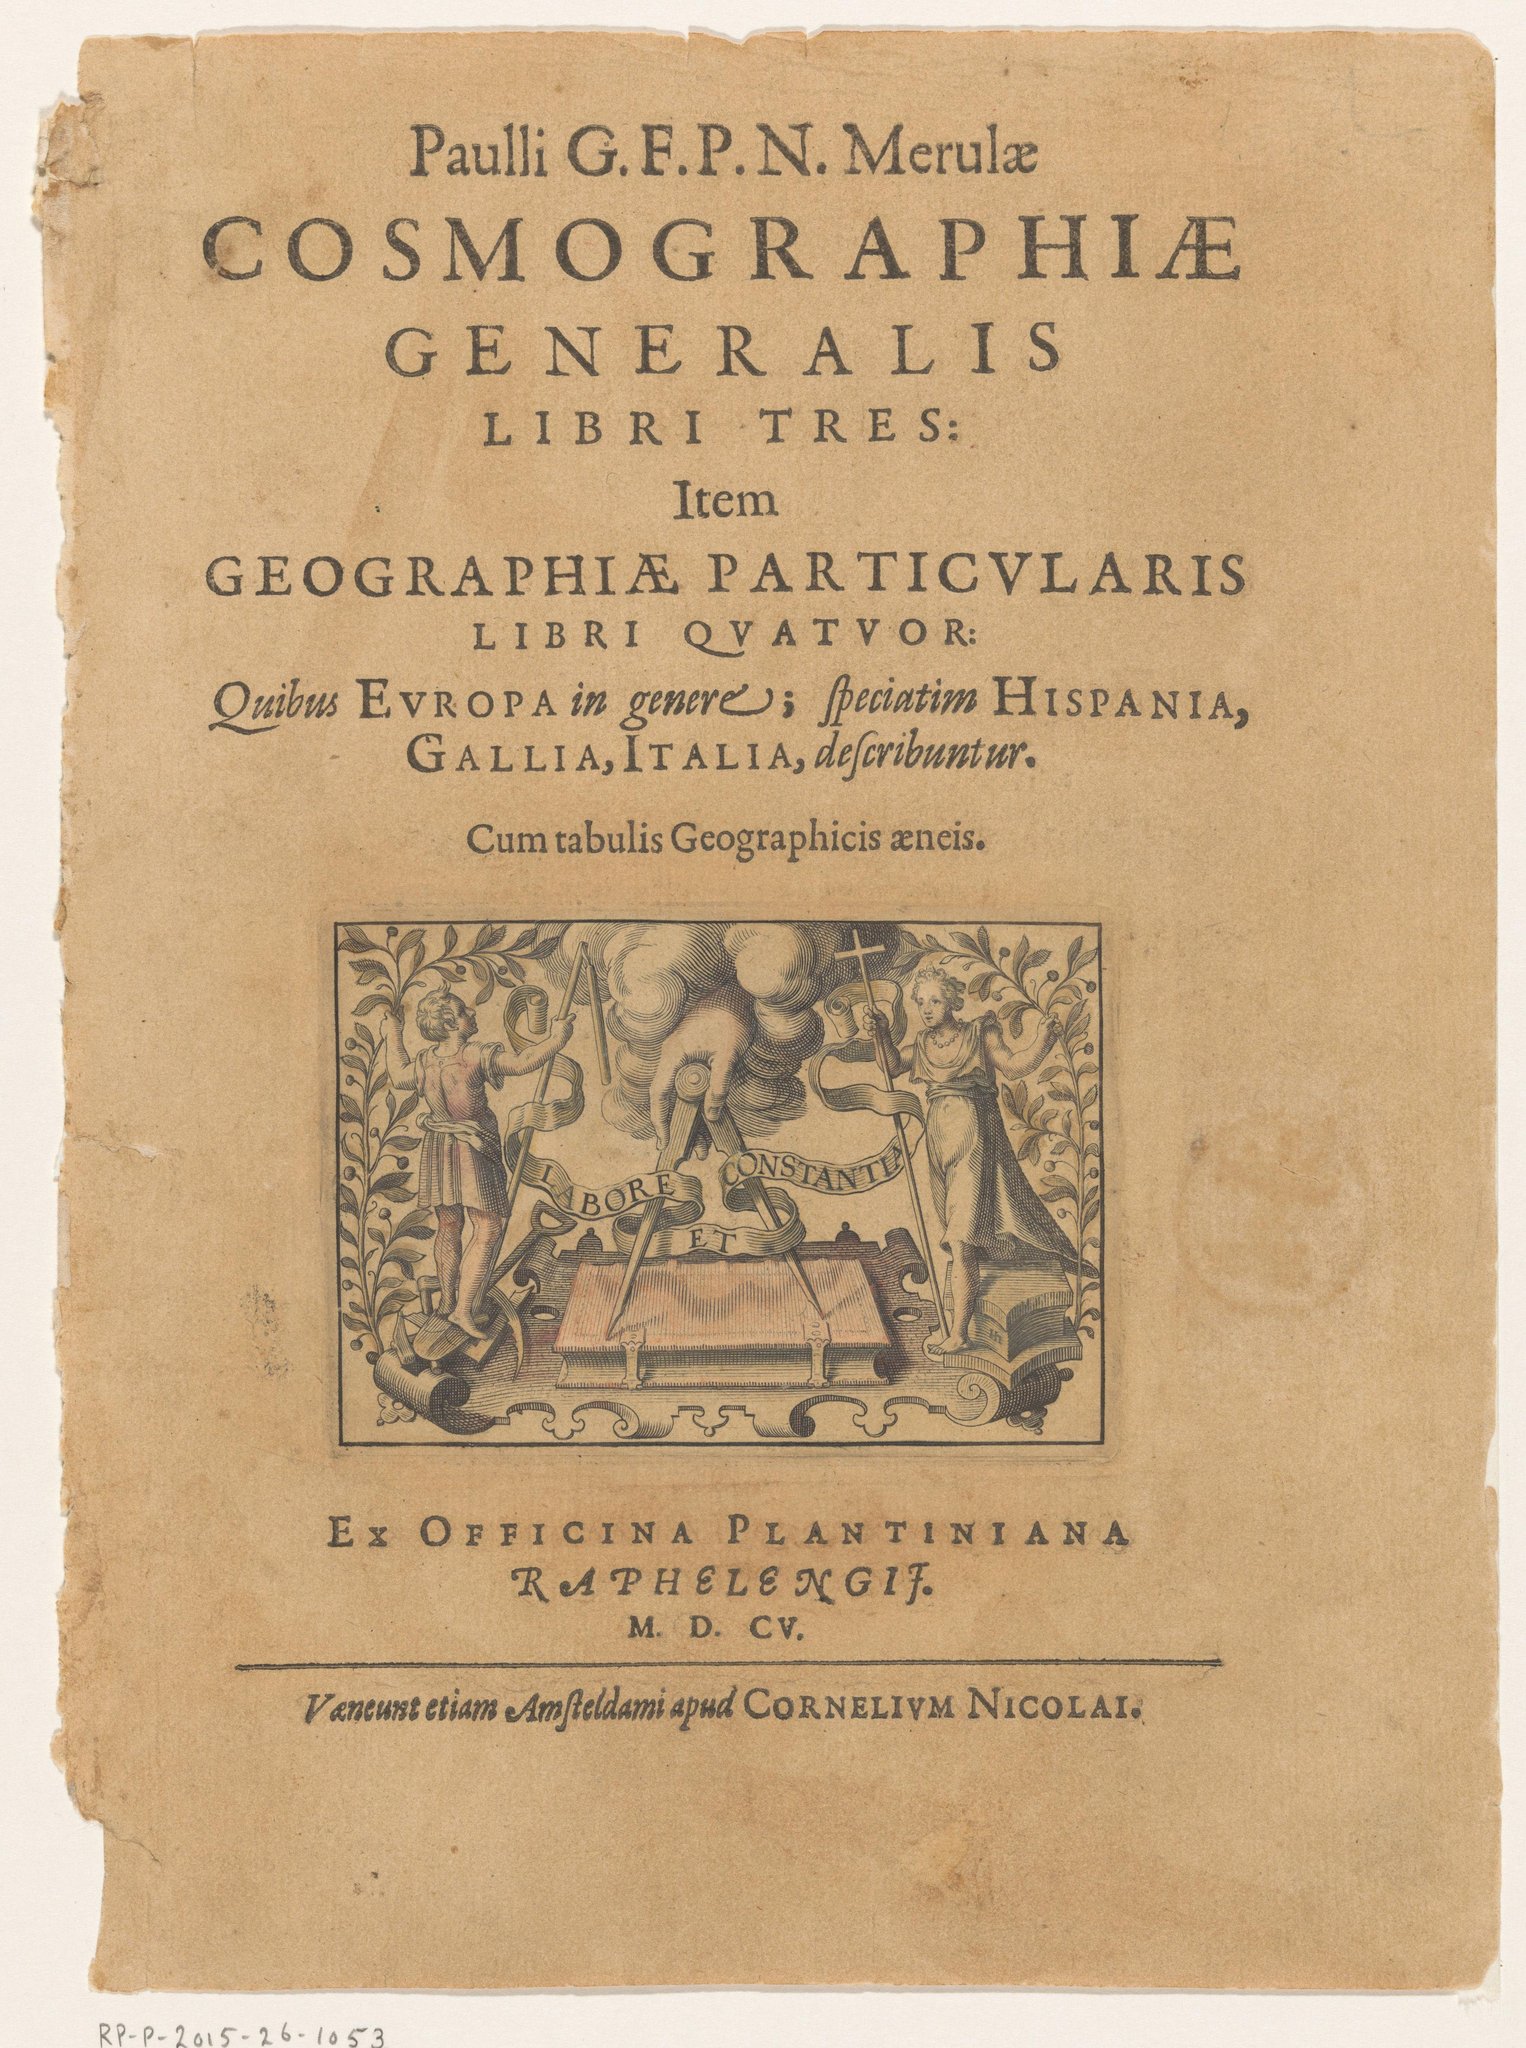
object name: print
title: Passer op een boek met Arbeid en Standvastigheid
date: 1605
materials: paper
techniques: engraving, hand coloring, letterpress printing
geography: amsterdam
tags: compasses, personification of agriculture, 'agricultura'; 'agricoltura', 'studio dell'agricoltura' (ripa), constancy, tenacity; 'costanza', 'tenacità' (ripa)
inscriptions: collector's mark: Lugt, collector's mark: Lugt 4780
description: Titelpagina voor: Merula, Paullus. Cosmographiae generalis libri tres. Leiden: Franciscus Raphelengius en Amsterdam: Cornelis Claesz., 1605.